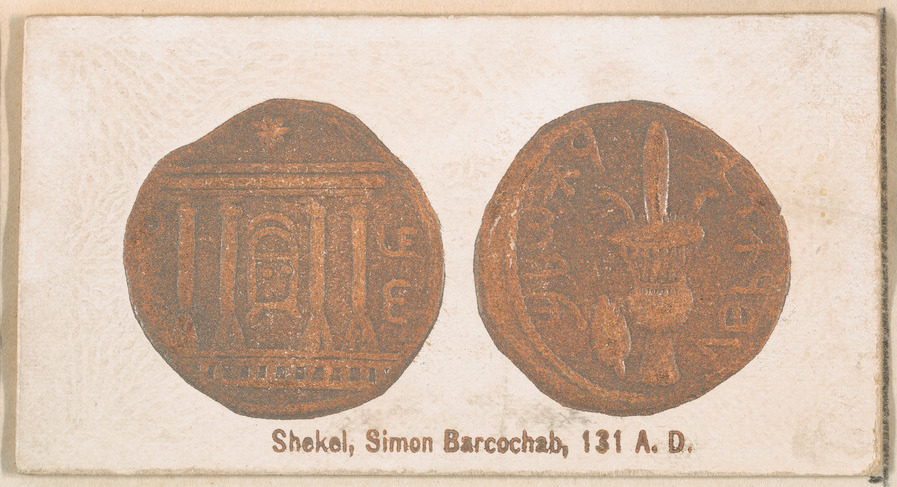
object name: print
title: Shekel, Simon Barcochab, 131 A.D., from the Ancient Coins series (N180) issued by Wm. S. Kimball & Co.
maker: william s. kimball & company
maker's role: publisher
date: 1888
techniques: color lithograph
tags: coins